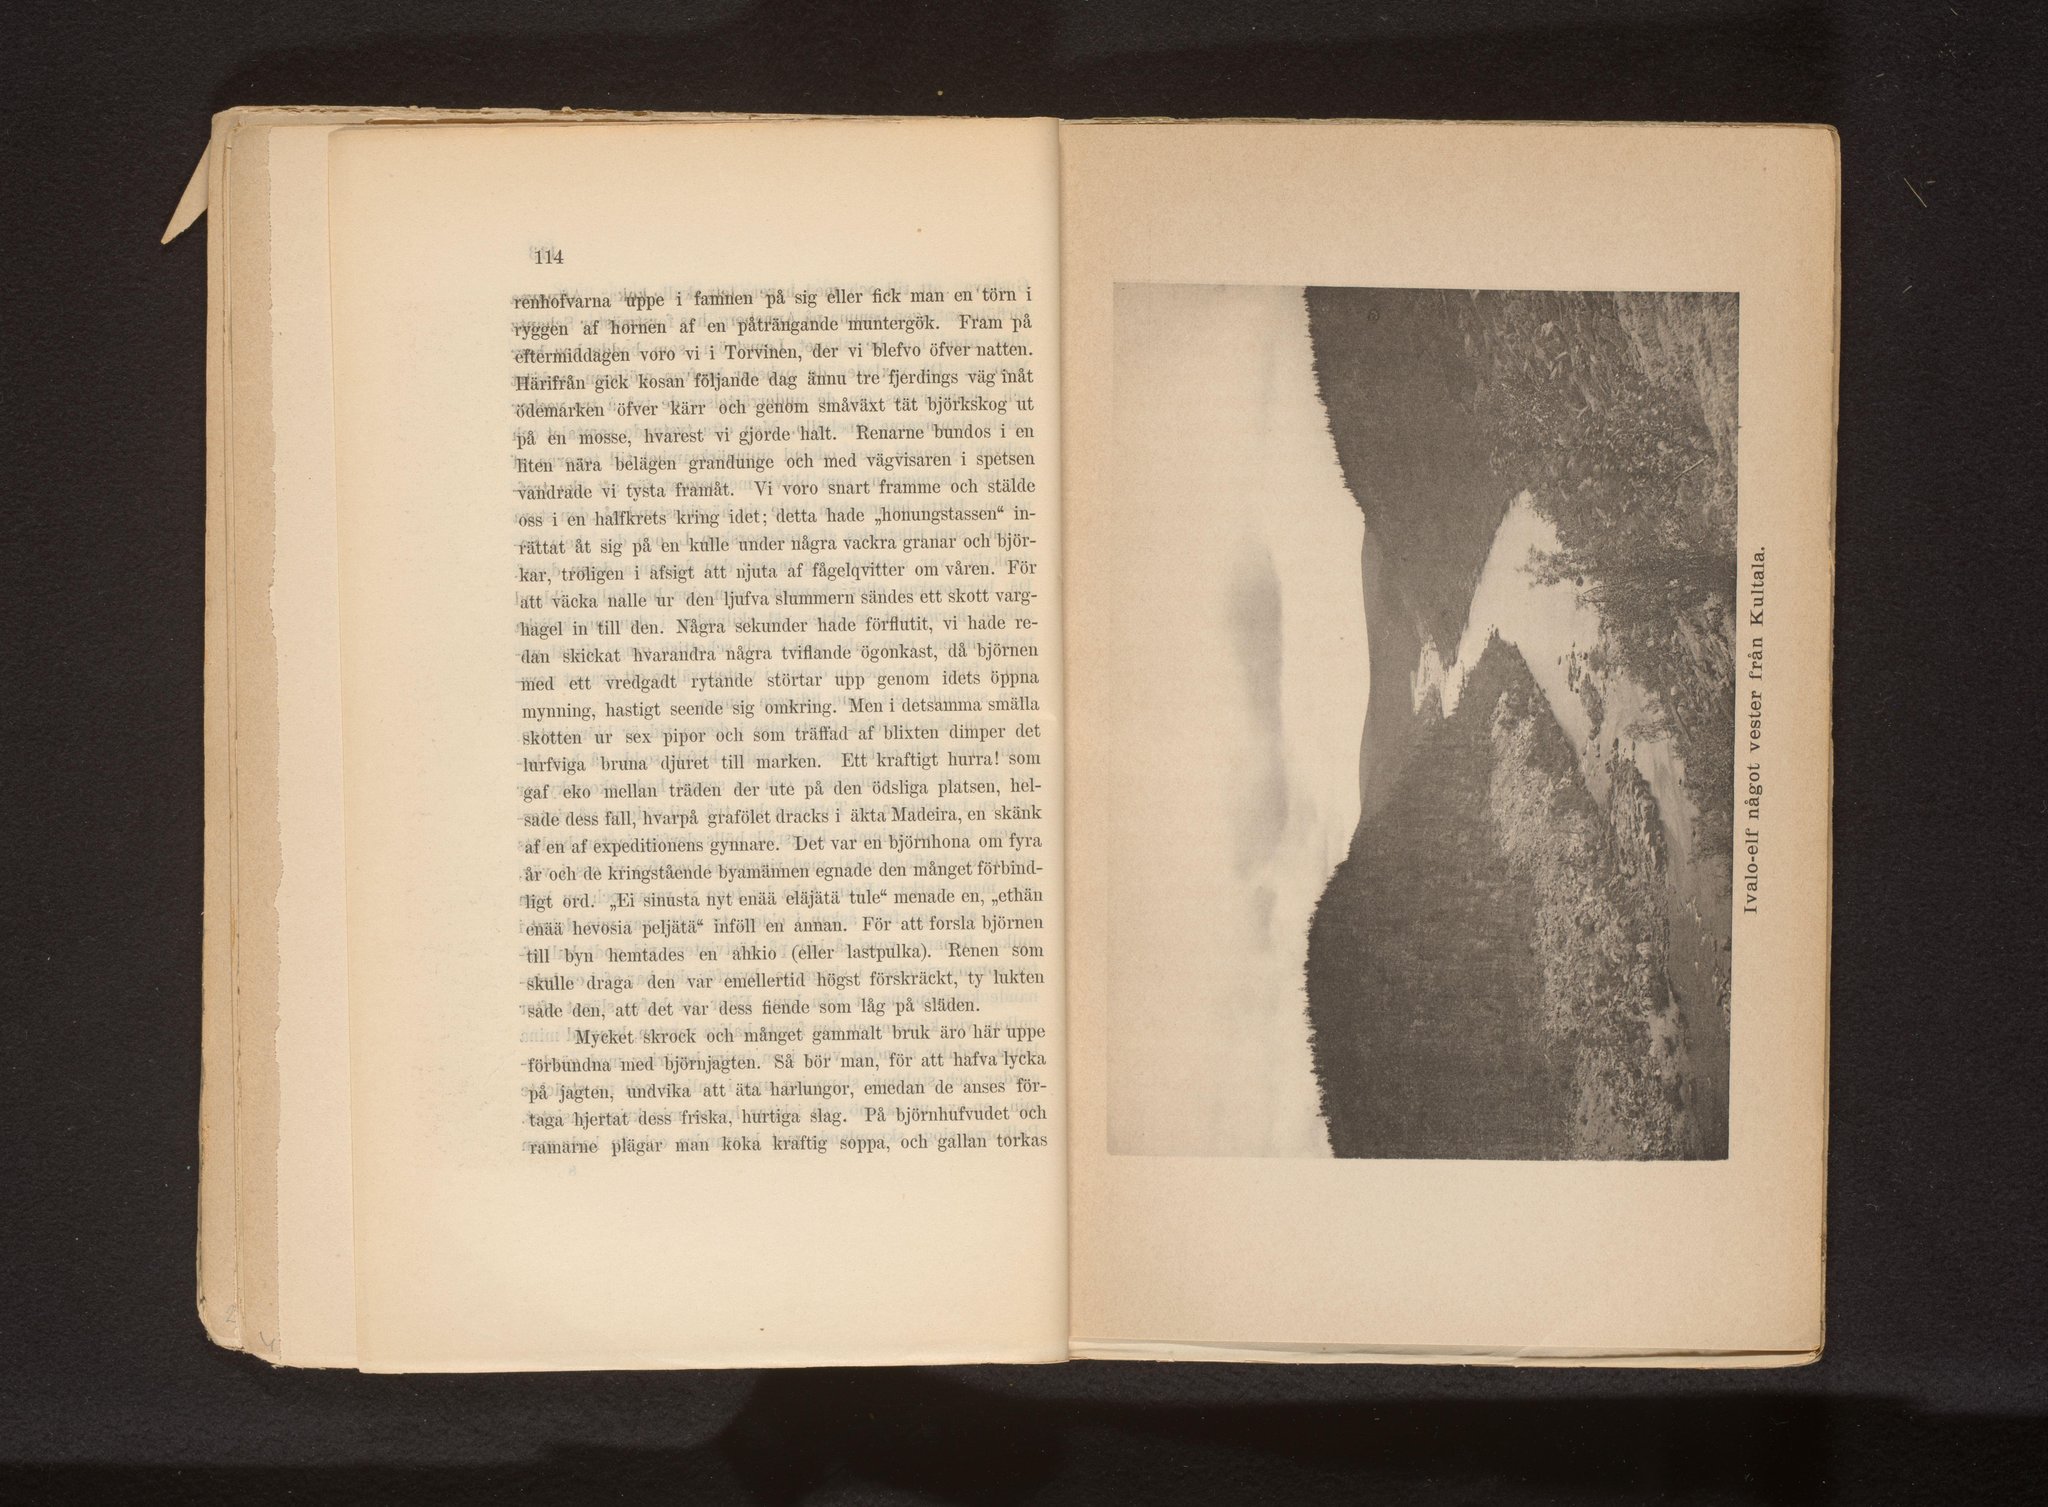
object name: page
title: Gezicht op de rivier Ivalo te Kultala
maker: karl granit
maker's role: fotograaf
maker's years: 1857-1894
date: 1875-1885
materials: paper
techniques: photograph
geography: berlin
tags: dale, valley, river